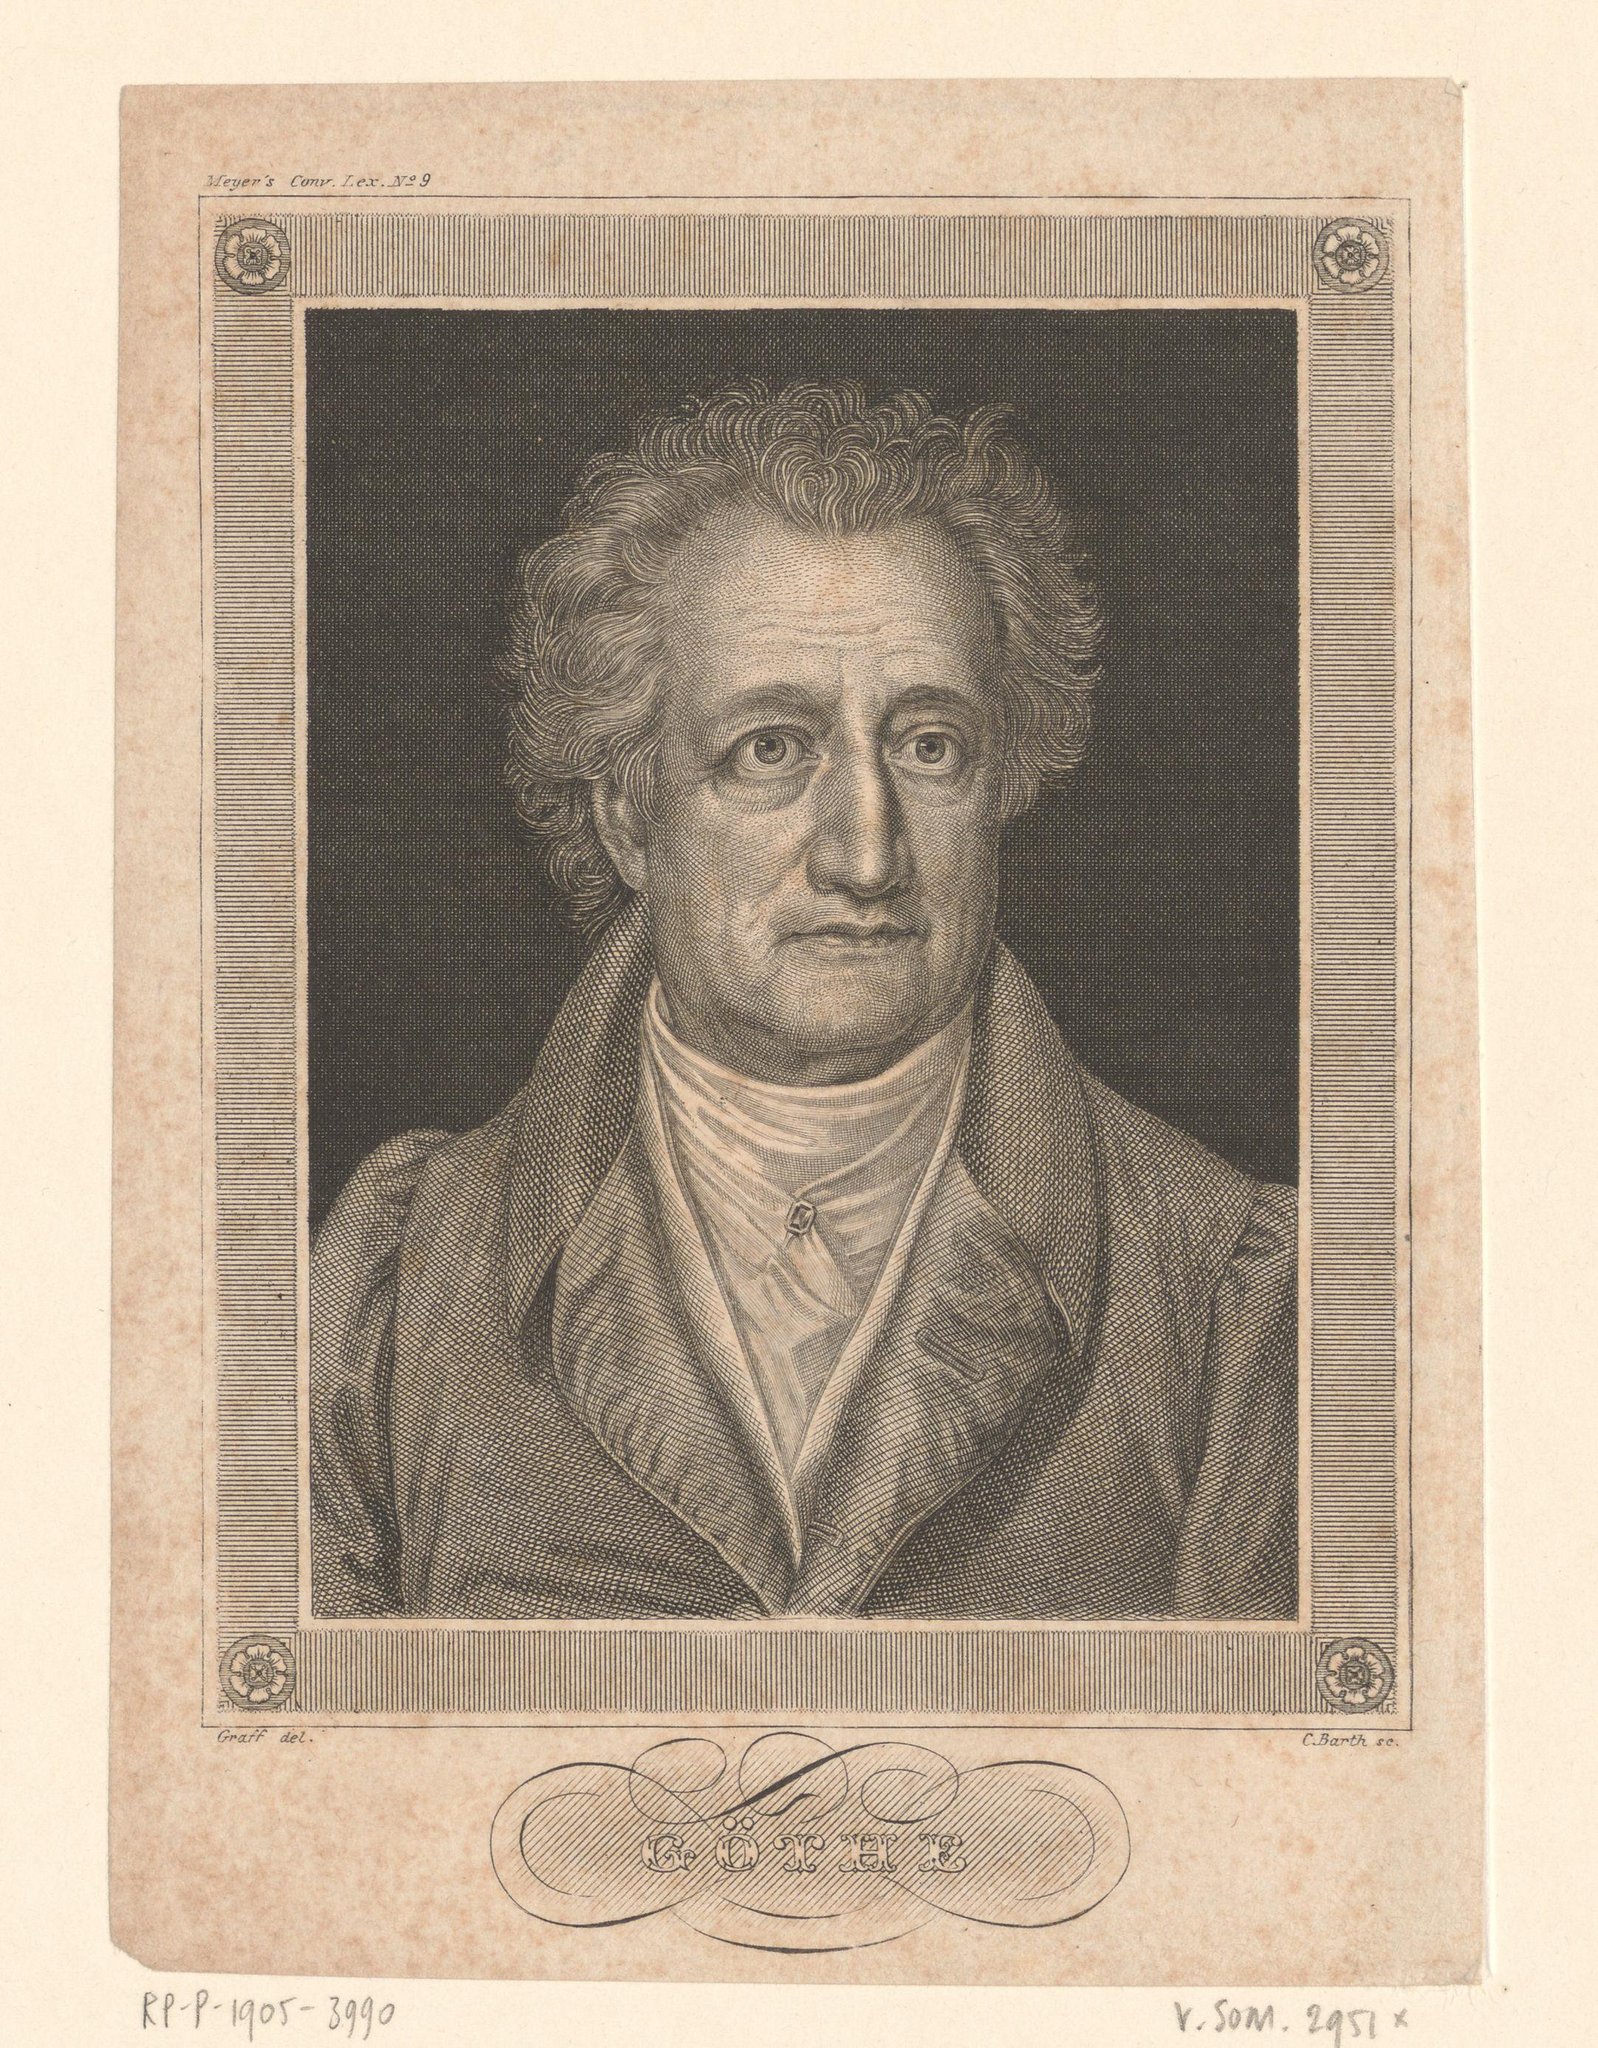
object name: book illustration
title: Portret van Johann Wolfgang von Goethe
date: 1828-1855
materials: paper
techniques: engraving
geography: hildburghausen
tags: draughtsman, johann wolfgang von goethe, historical persons, portrait of a writer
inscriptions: collector's mark: Lugt 2228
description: Prent uit: Meyer, Joseph. Das Grosse Conversations-Lexikon für die gebildeten Stände. Hildburghausen: Bibliographisches Institut, [1828-1852].